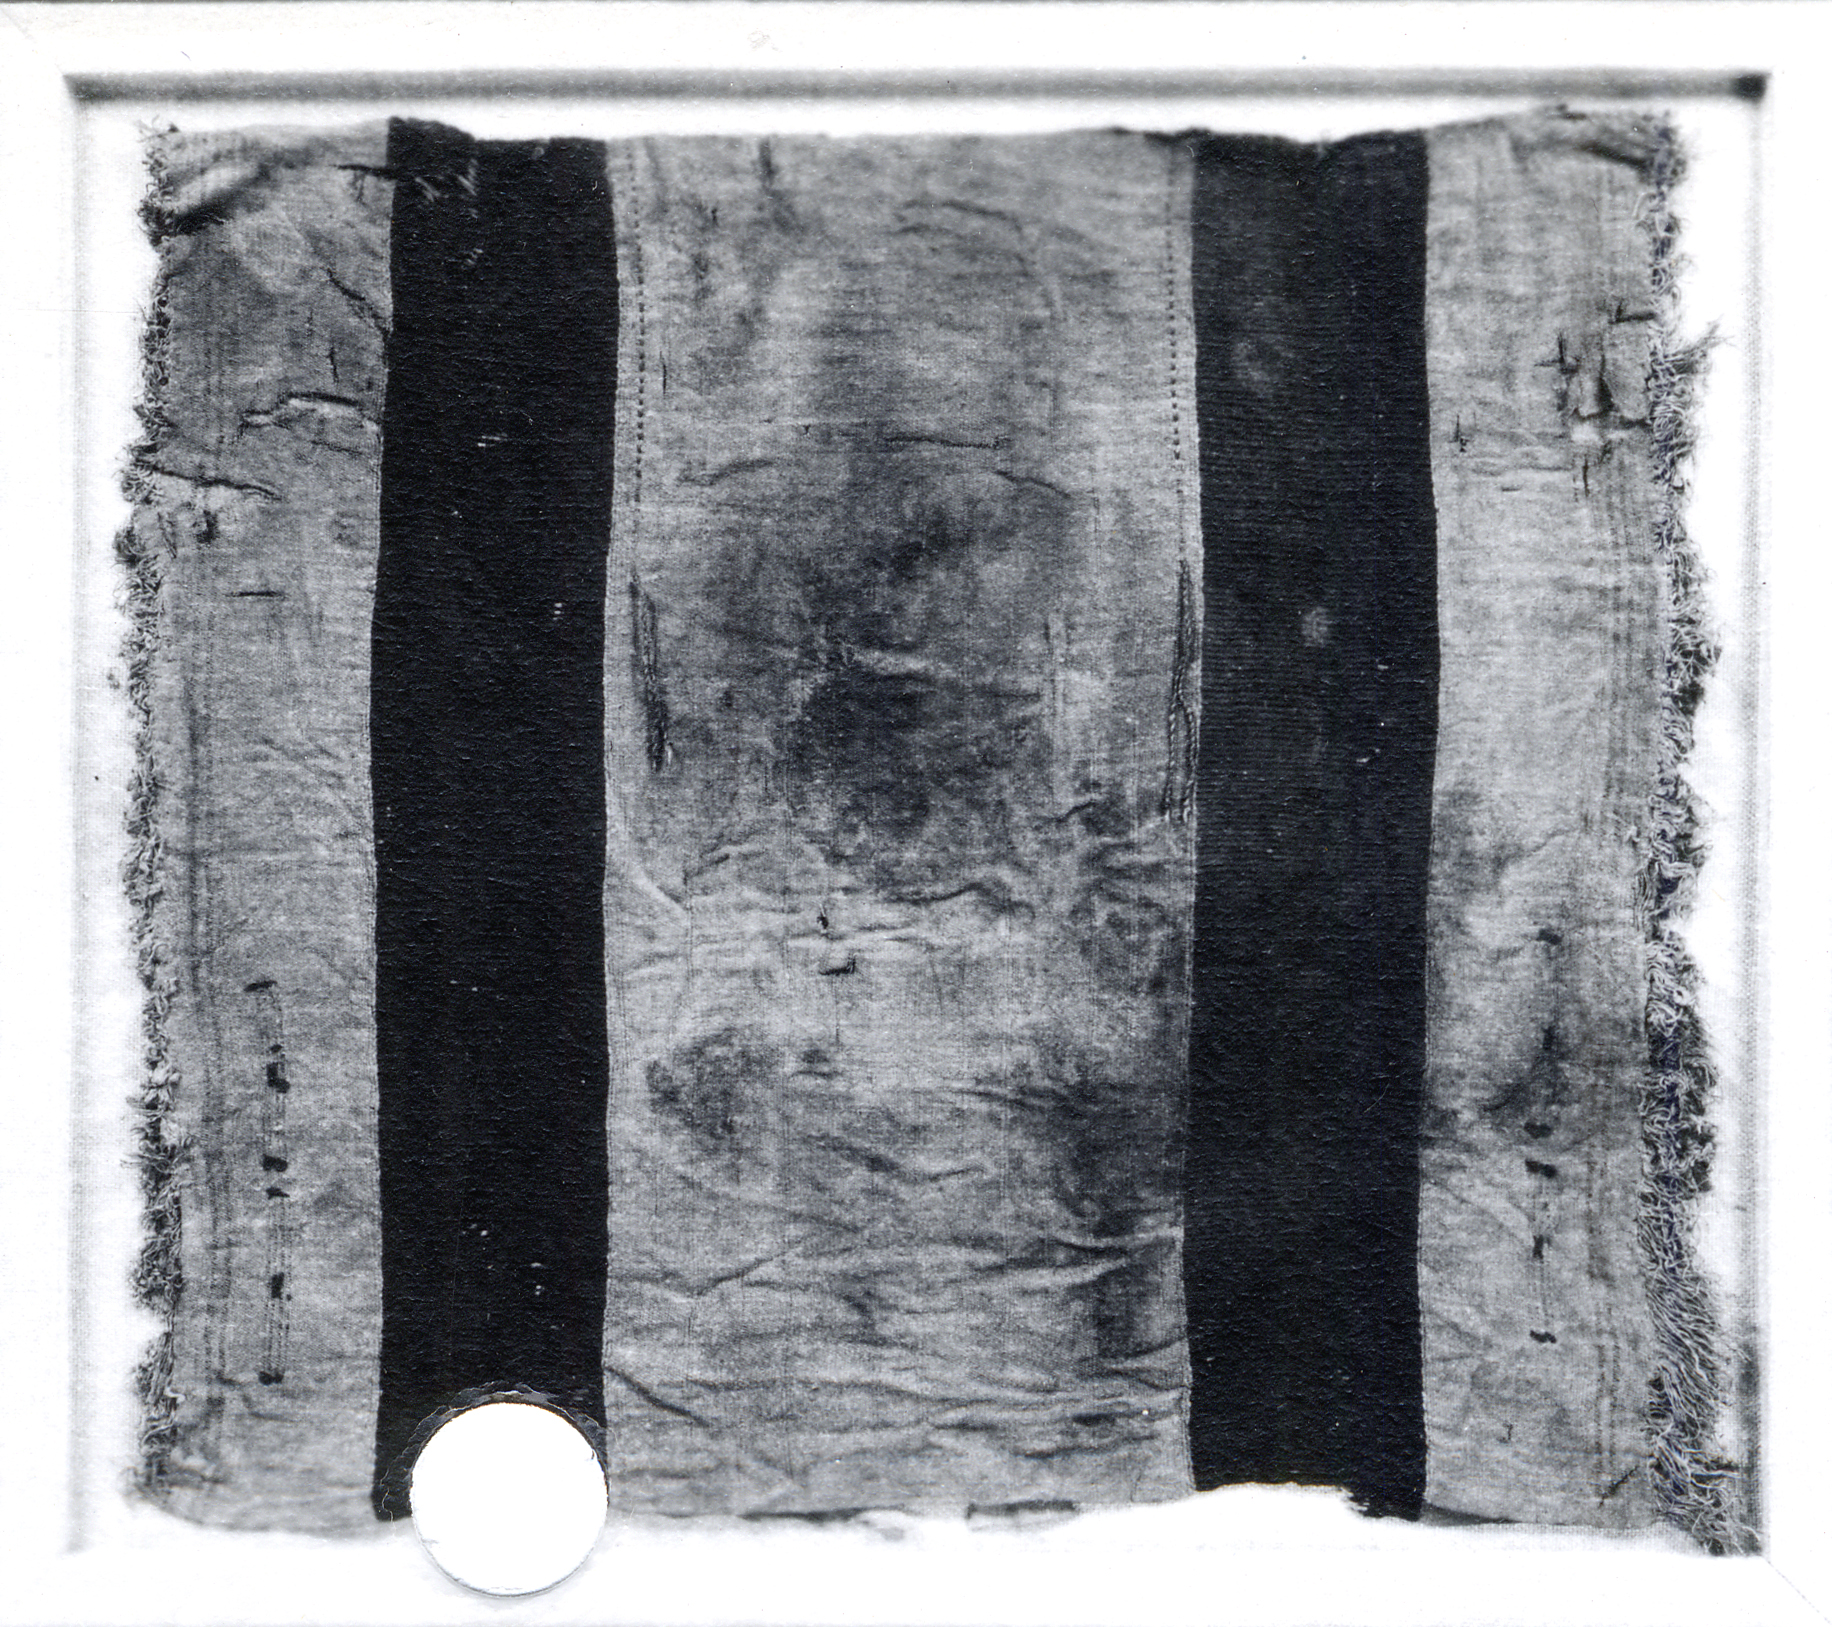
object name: dress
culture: coptic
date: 301-400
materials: linen, wool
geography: egypt